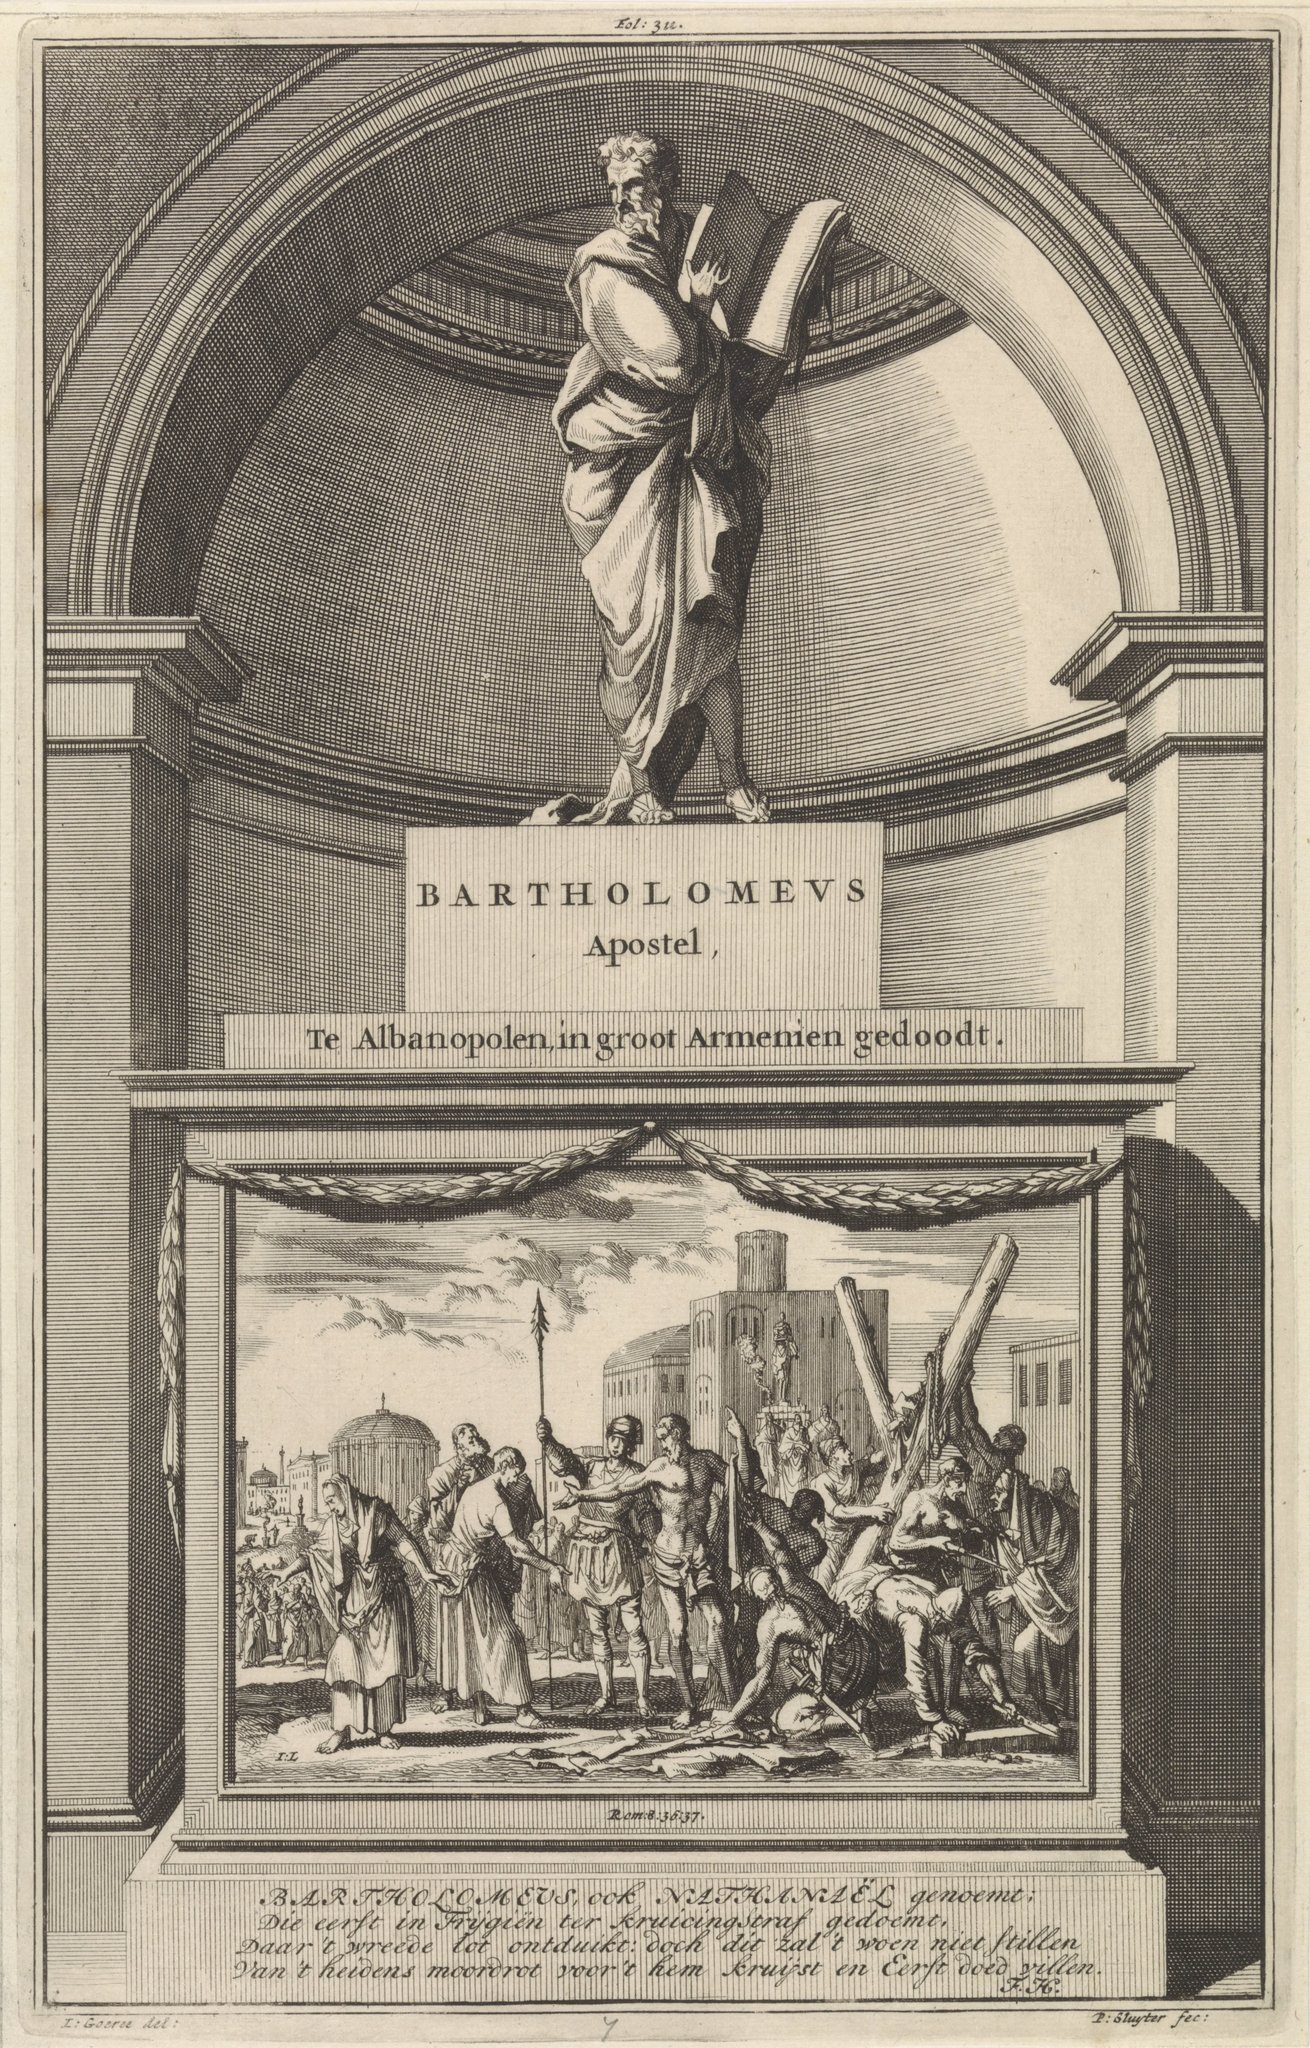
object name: print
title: Bartholomeus, Apostel. Te Albanopolen, in groot Armenien gedoodt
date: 1698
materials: paper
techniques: engraving, etching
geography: amsterdam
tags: the apostle bartholomew; possible attributes: book, devil or dragon at feet, knife, scroll, flayed skin, staff, bartholomew flayed alive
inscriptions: number: ‘7’, collector's mark: Lugt 2228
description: De apostel Bartolomeüs met een opengeslagen boek in zijn handen. Bartolomeüs staat op een sokkel waar op de voorzijde zijn marteldood in beeld is gebracht. Prent middenboven gemerkt: Fol: 311.